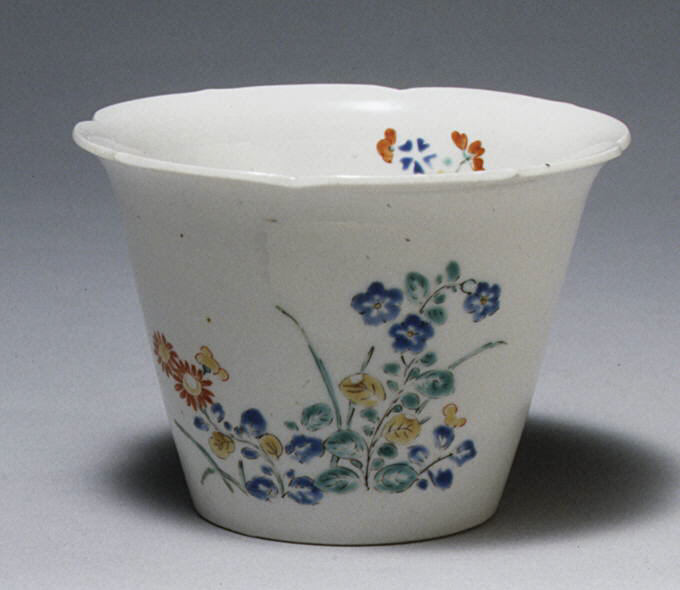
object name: beaker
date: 1700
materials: hard paste porcelain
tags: flowers